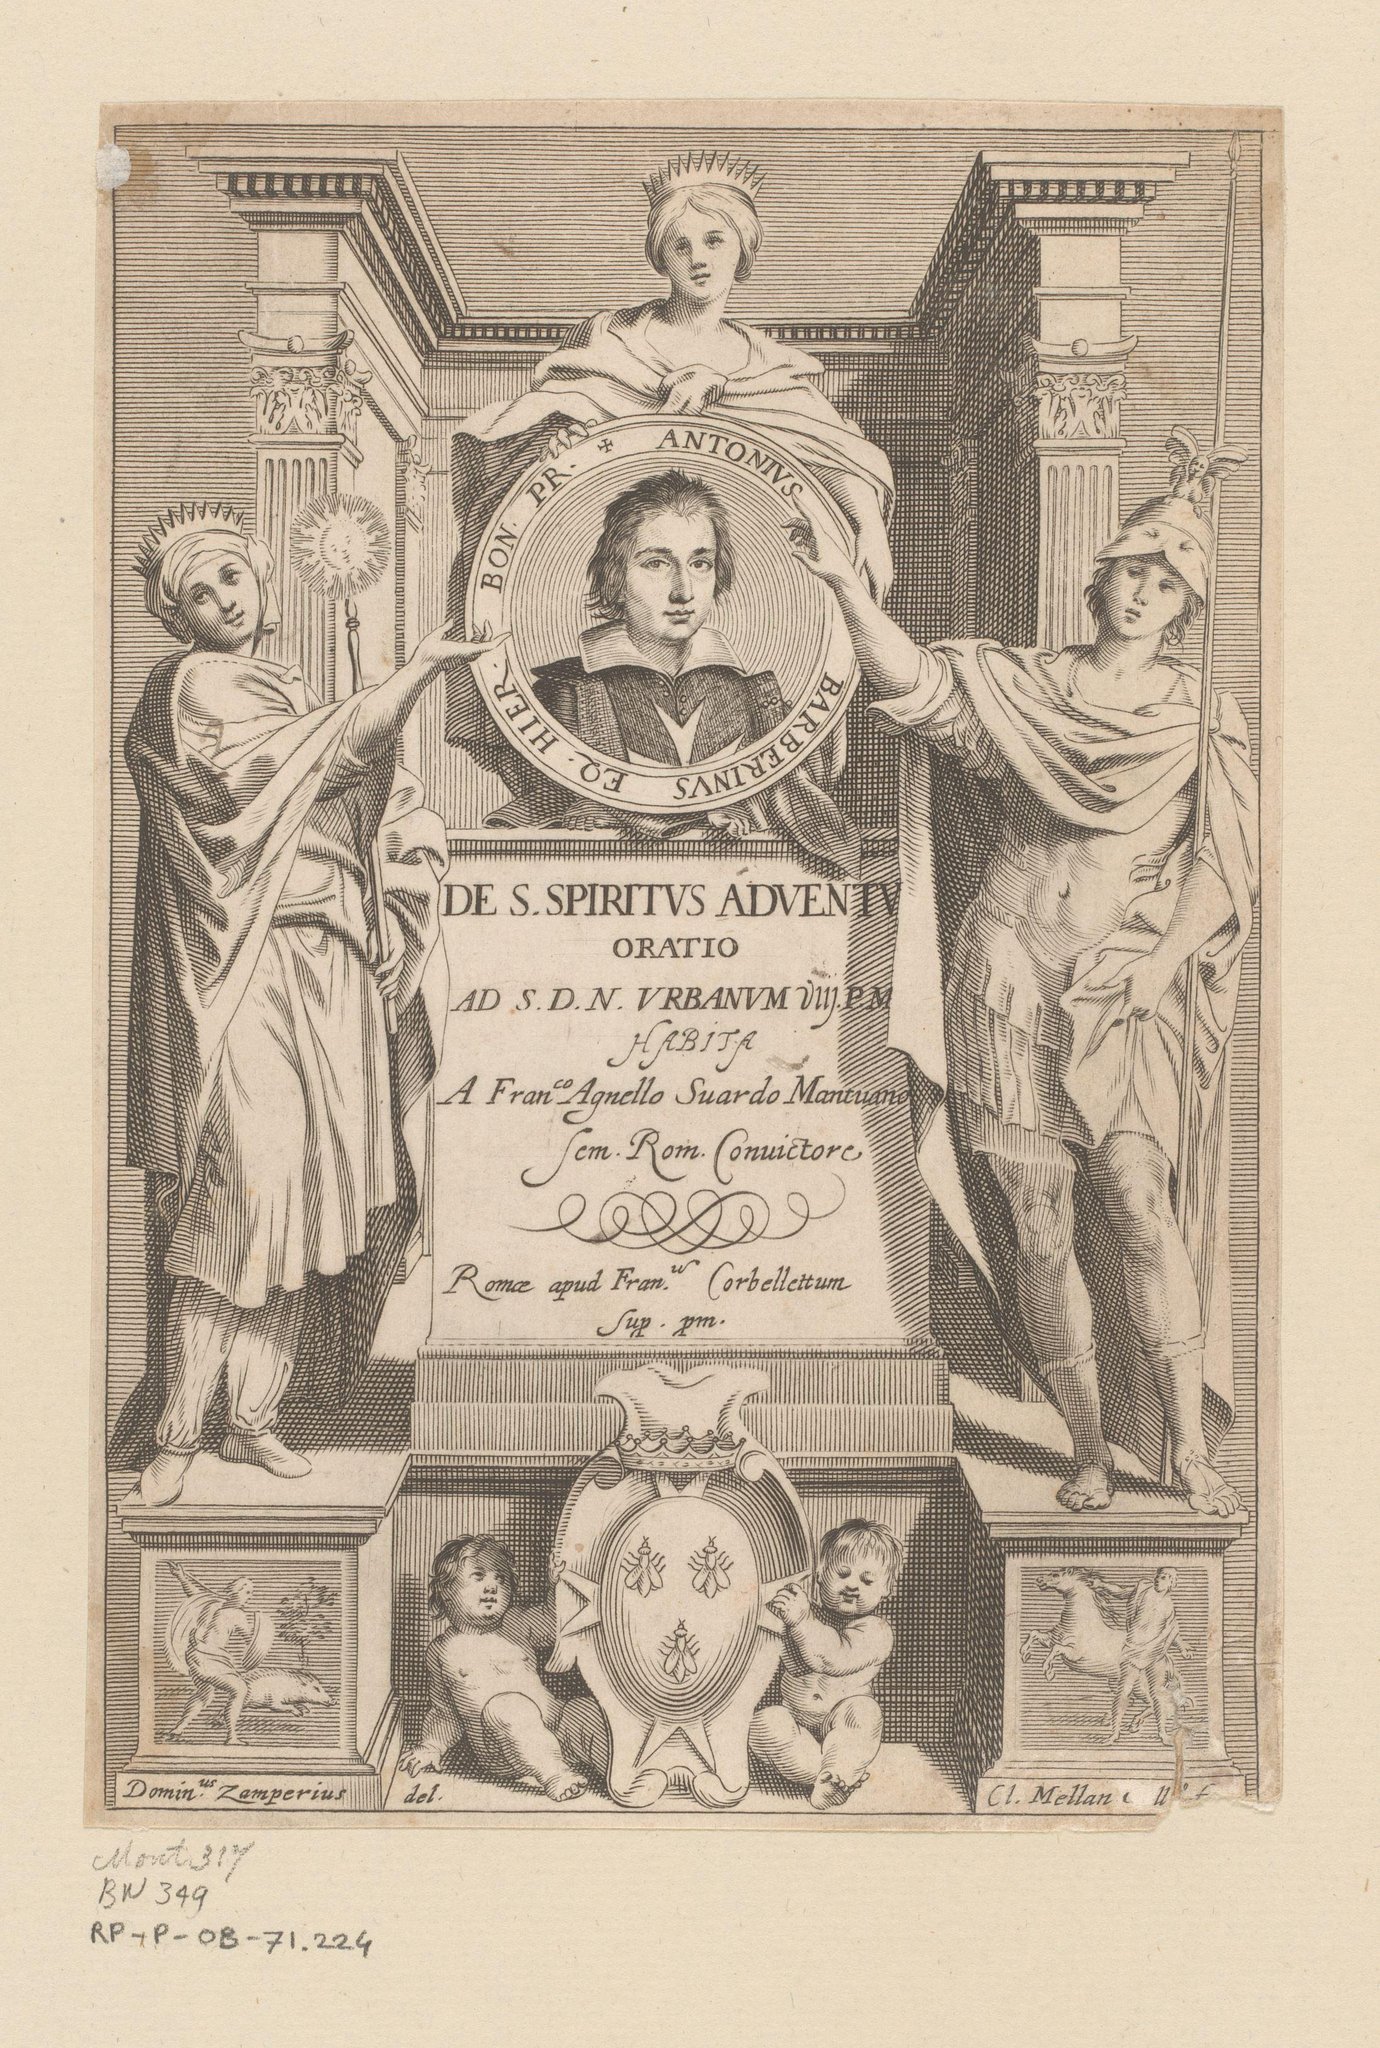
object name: print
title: Titelpagina voor: Francesco Agnello Suardo, De Sancti Spiritus adventu oratio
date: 1625-1637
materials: paper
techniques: engraving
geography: italy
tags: rome, clergyman, antonio barberini (ii), historical persons, armorial bearing, heraldry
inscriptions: collector's mark: Lugt 240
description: Titelpagina voor: Suardo, Francesco, Agnello. De Sancti Spiritus adventu oratio. Rome: Franciscus Corbelletti, s.d.